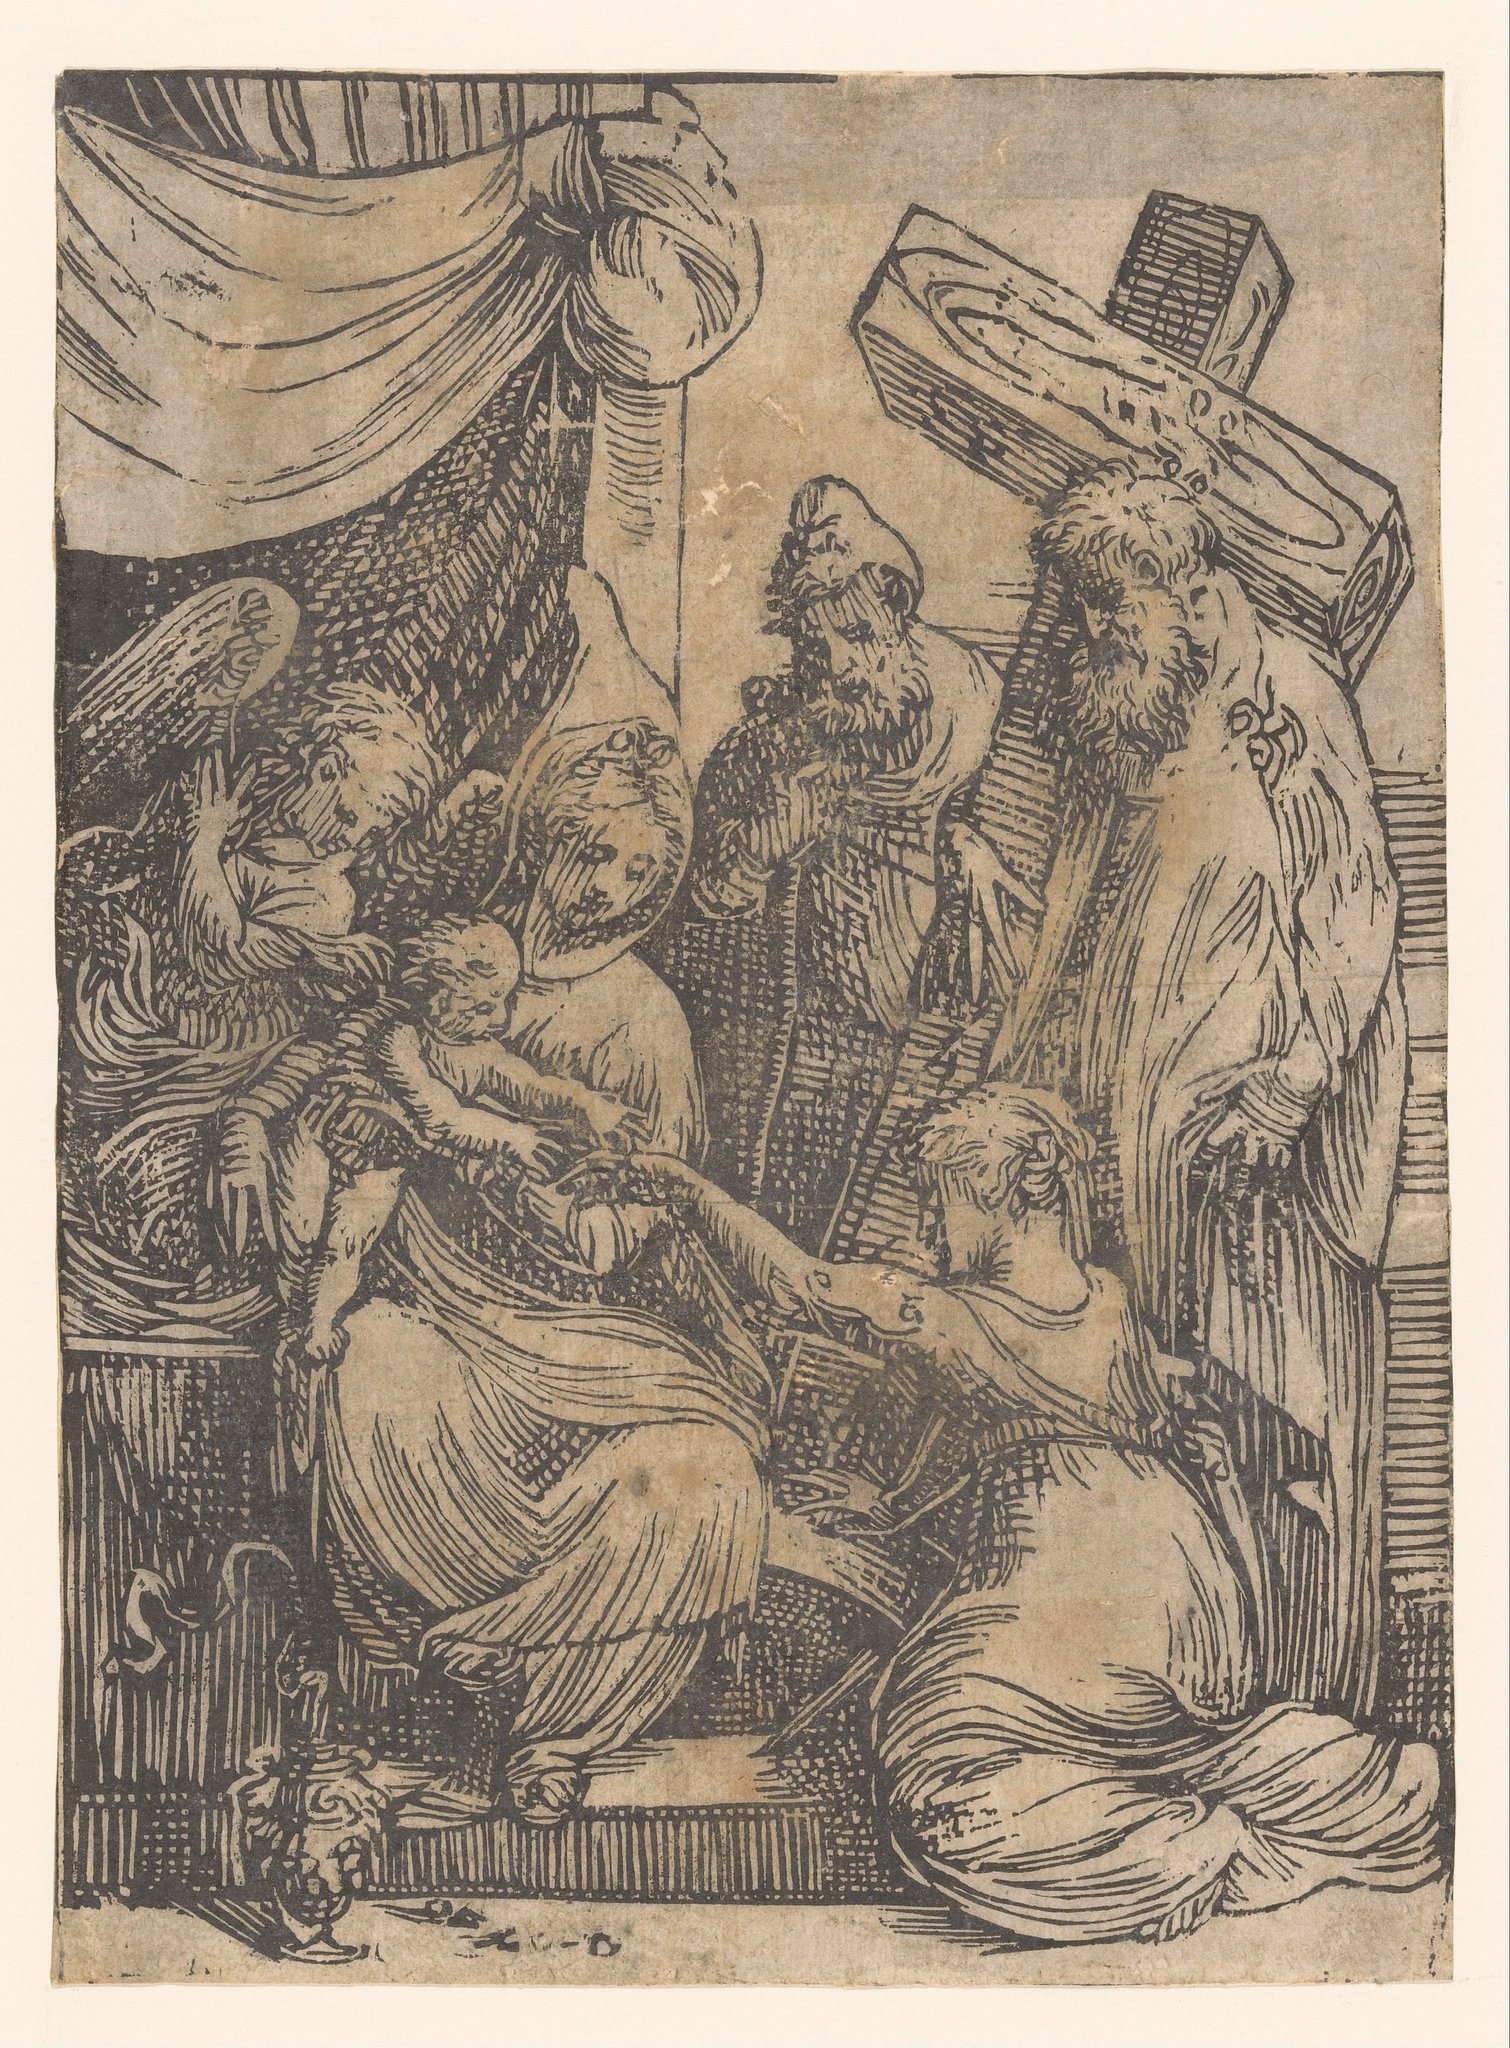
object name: print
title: Mystieke huwelijk van de heilige Catharina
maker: schiavone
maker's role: draughtsman, painter, print maker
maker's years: 1500-1563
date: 1550-1560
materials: paper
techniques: woodcut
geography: italy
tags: the mystic marriage of st. catherine of alexandria with the infant christ: the christ-child puts a ring on her finger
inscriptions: collector's mark: Lugt 2760, collector's mark: Lugt 2228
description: Maria houdt het Christuskind vast terwijl deze een ring om de vinger schuift van de heilige Catharina die voor hem knielt. Links een engel en rechts twee staande heiligen.